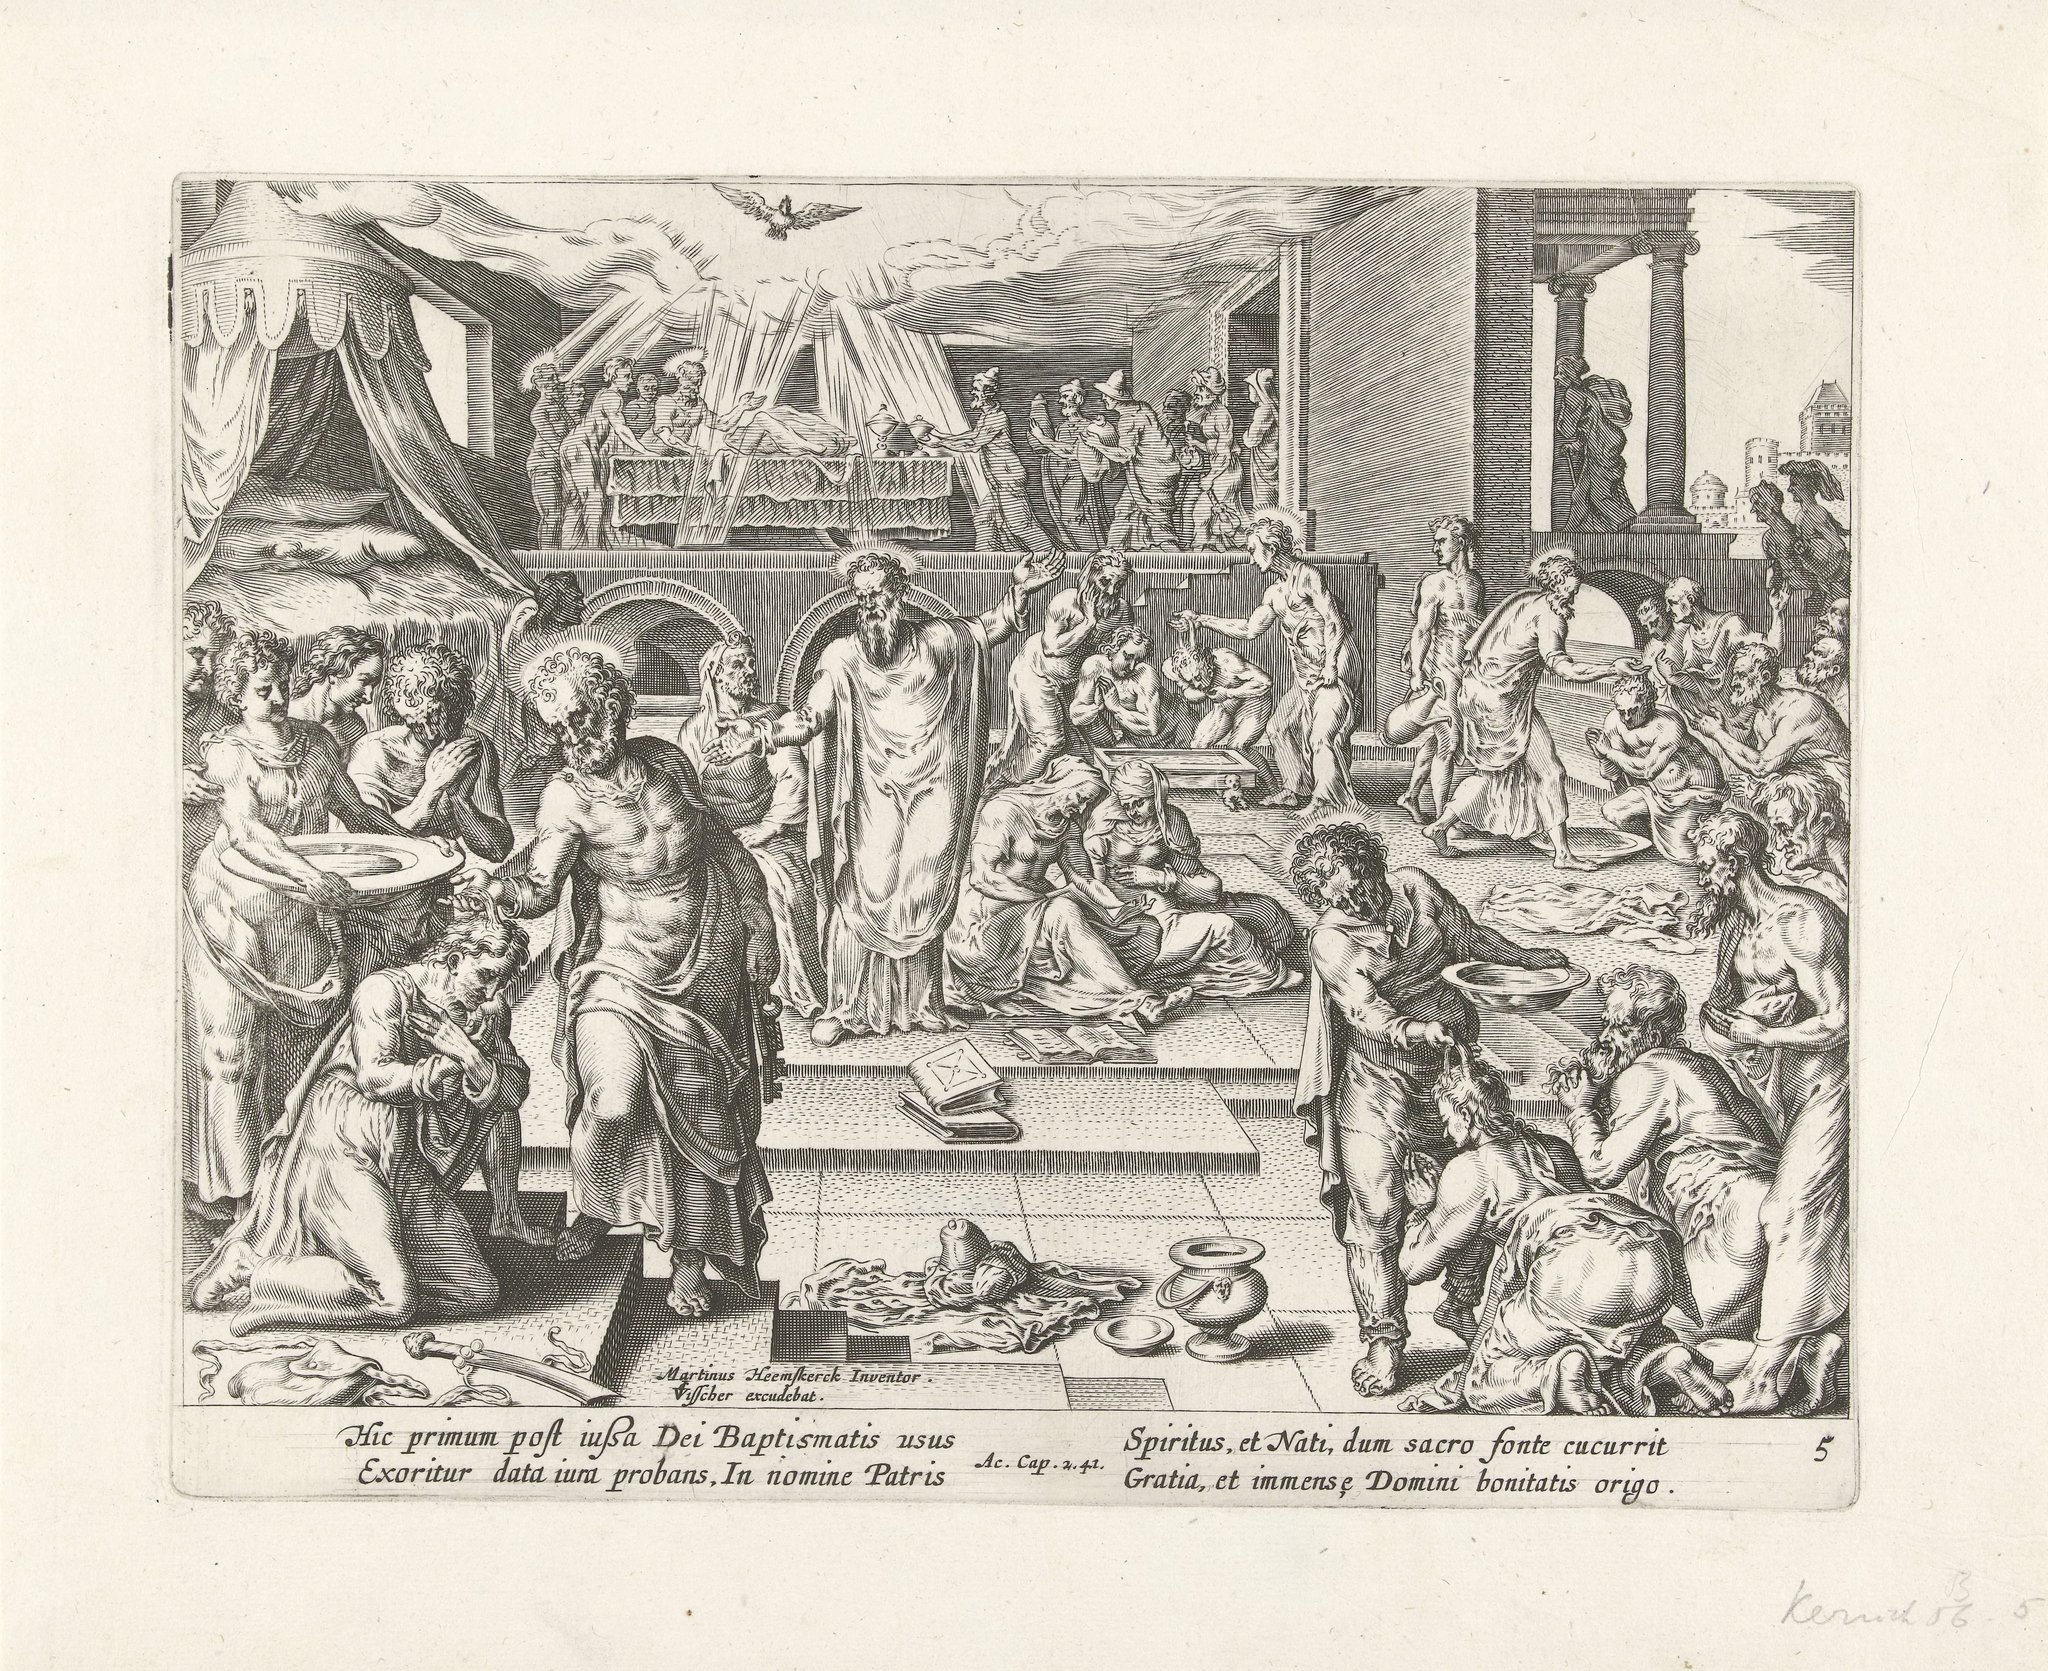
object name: print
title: Handelingen van de apostelen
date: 1643-1646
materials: paper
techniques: engraving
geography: amsterdam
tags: disciples preaching and baptizing (in general), pentecost: the holy ghost descends upon (mary and) the apostles, sometimes paul and/or representatives of the nations present (acts 2:1-4)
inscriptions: collector's mark: Lugt 2228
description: Apostelen dopen nieuwe gelovigen in Jeruzalem. In de achtergrond de uitstorting van de Heilige Geest tijdens pinksteren. De prent heeft een Latijns onderschrift en maakt deel uit van een 35-delige serie met als onderwerp de Handelingen van de apostelen.